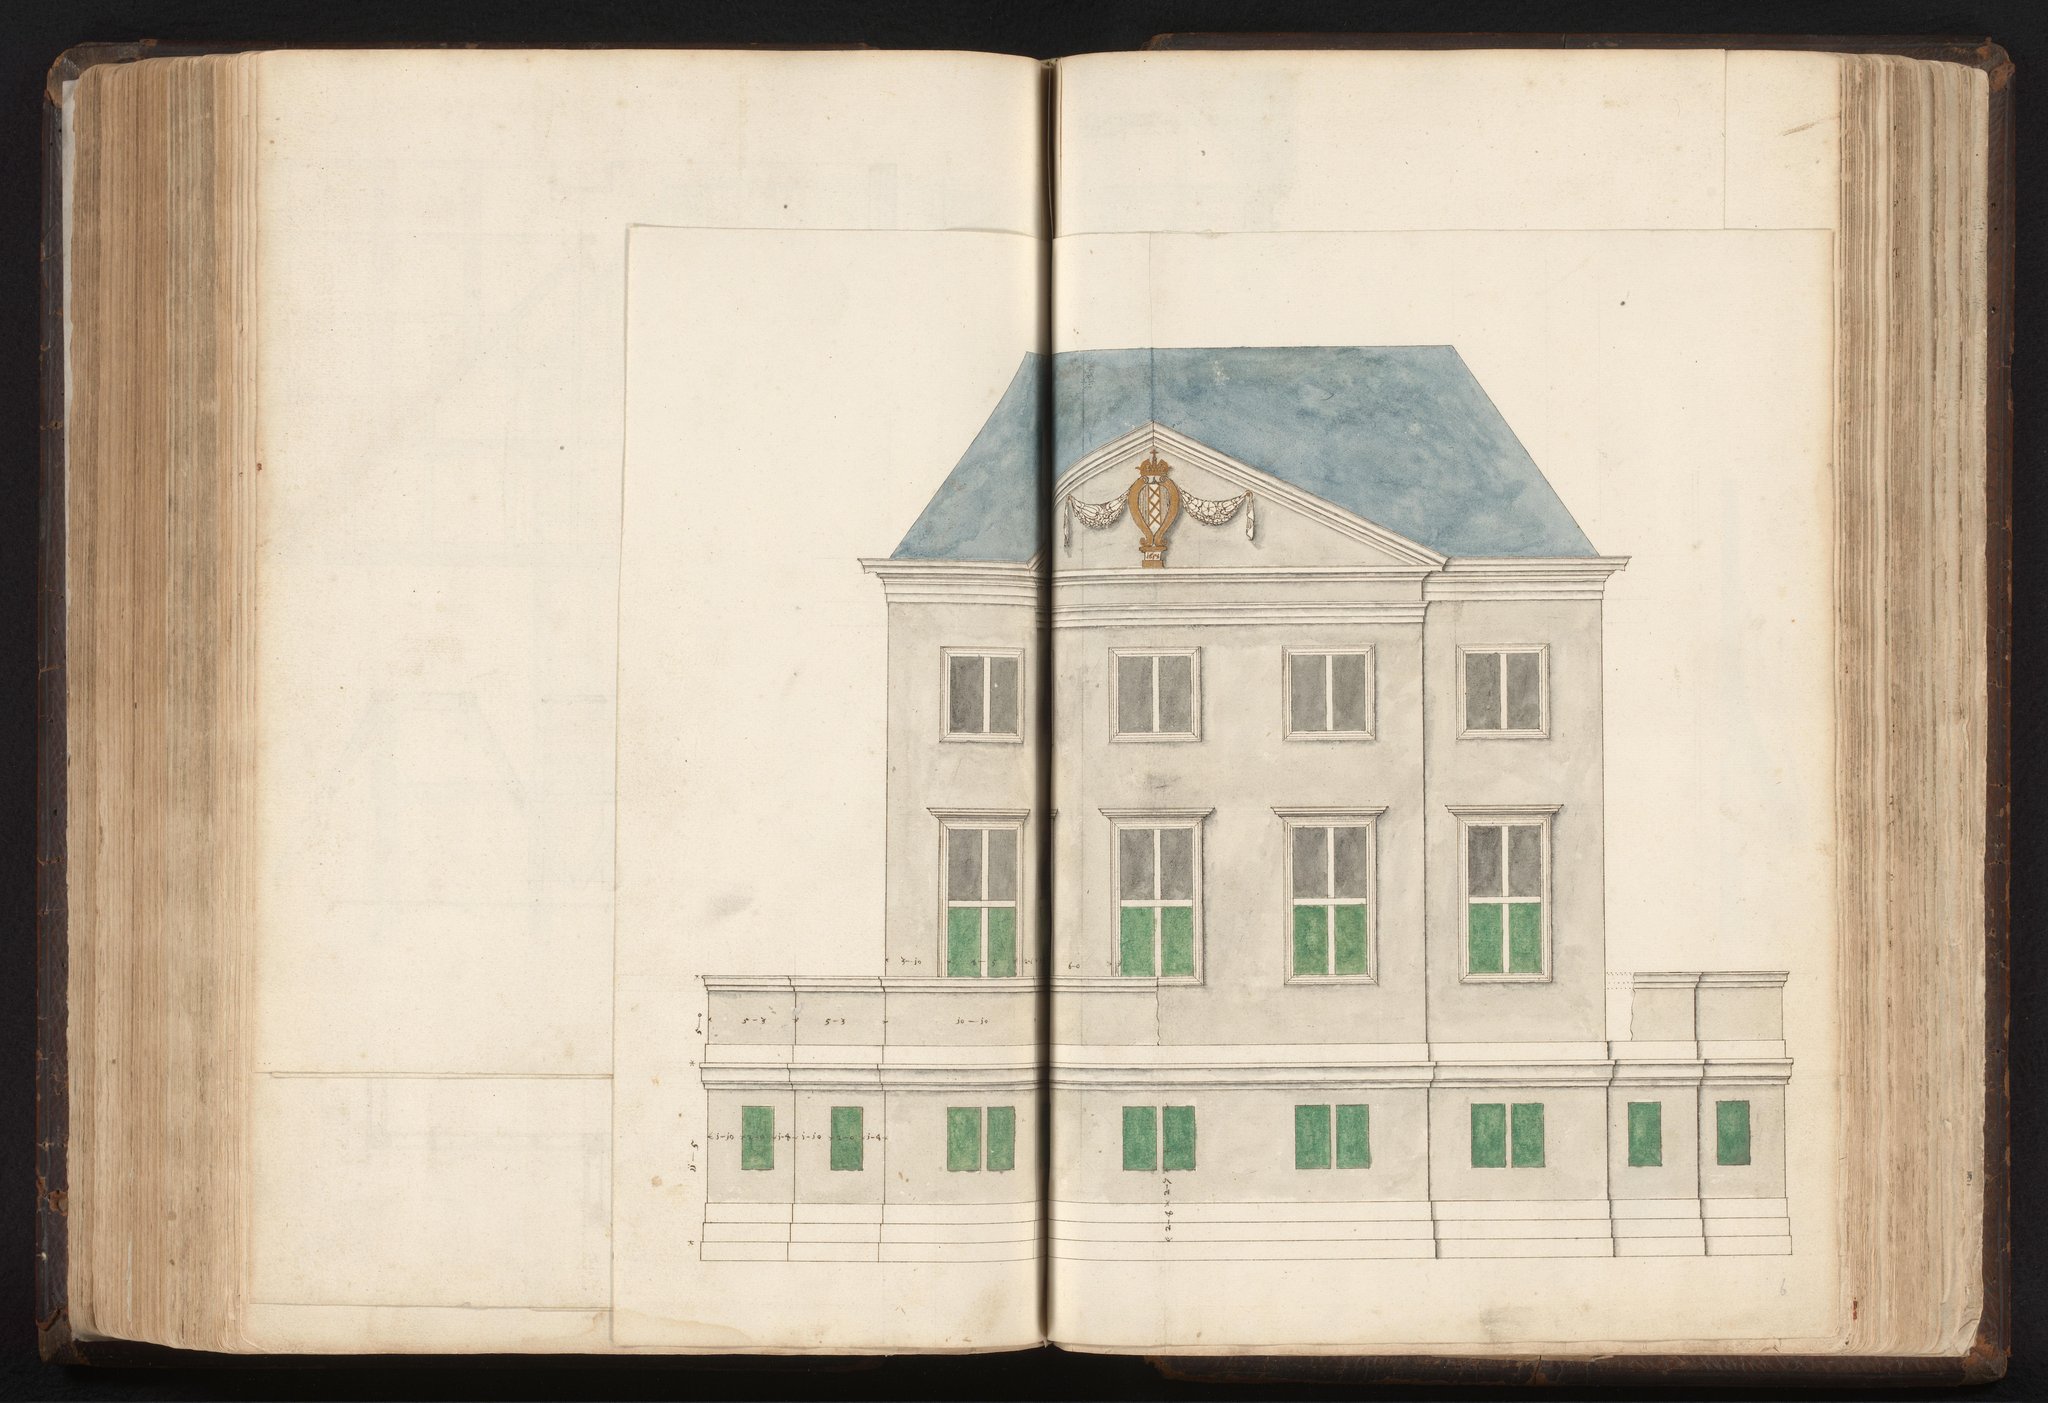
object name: album leaf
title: Gevel van een Blokhuis in de Amstel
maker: Anonymous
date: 1650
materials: paint, ink, paper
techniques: brush, pen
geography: amsterdam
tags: building activities, fortifications, military engineering, armorial bearing, heraldry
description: Mogelijk de achtergevel, met afmetingen. Tekening maakt deel uit van een album.